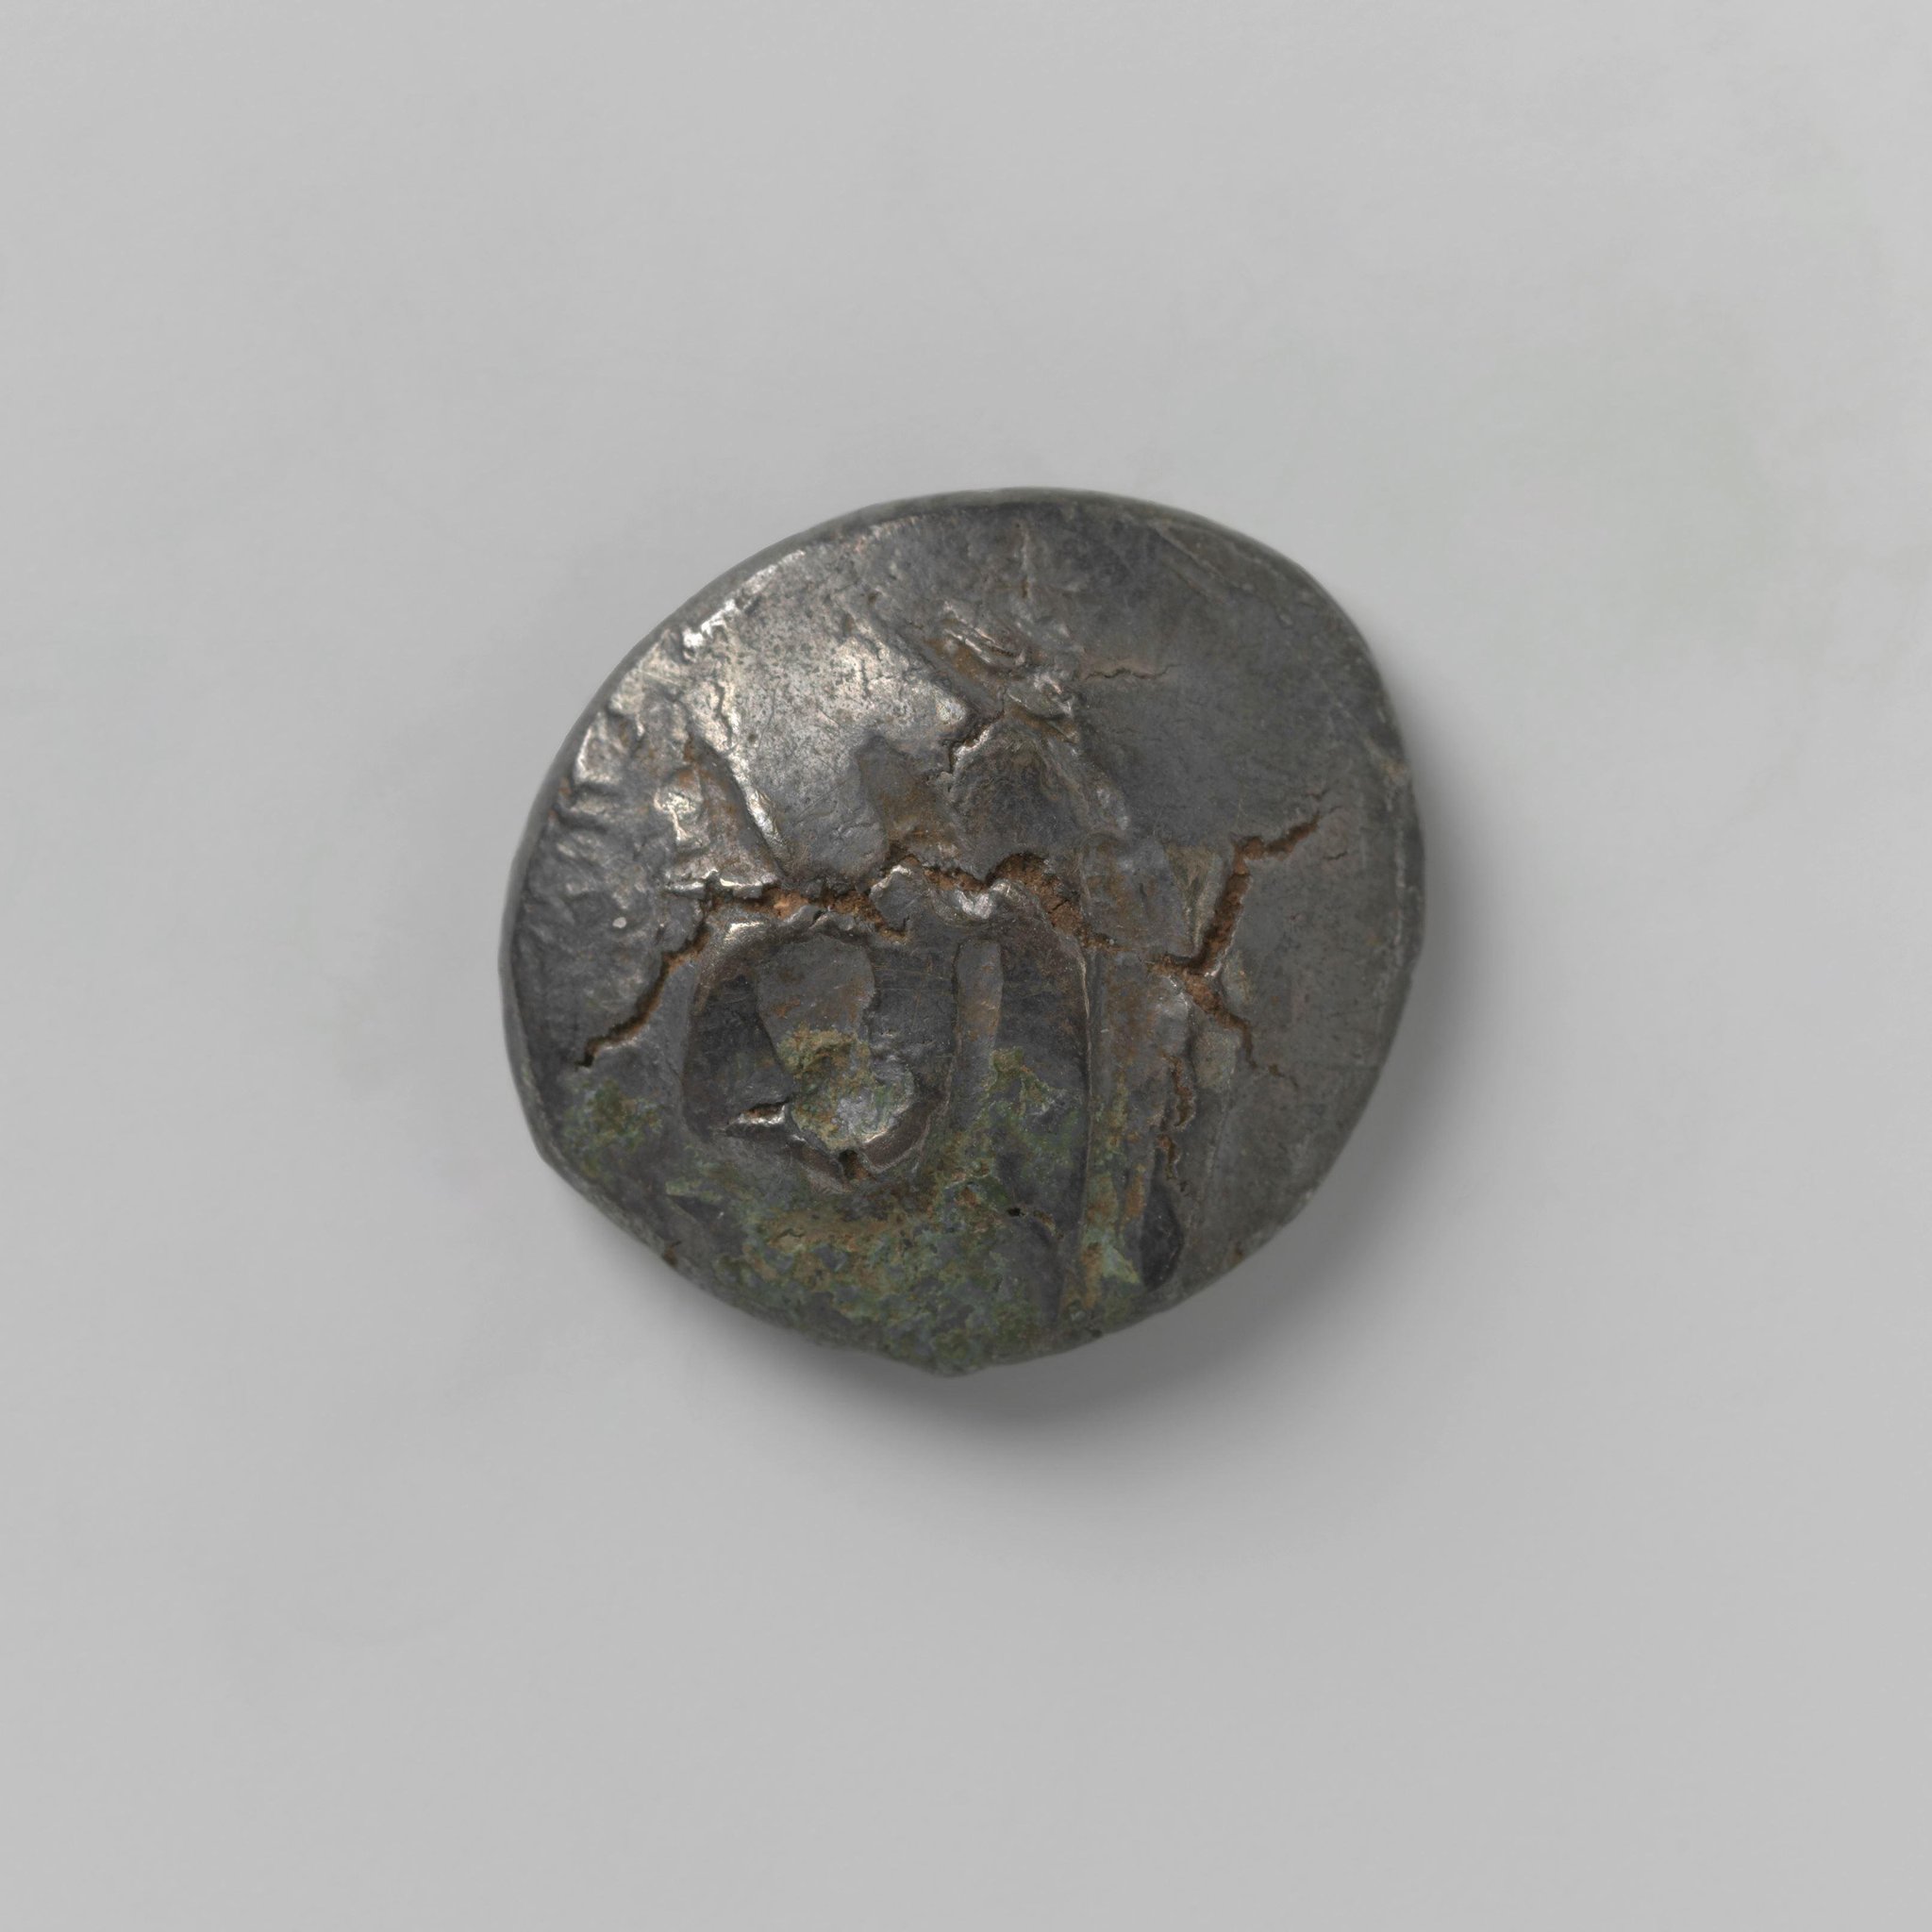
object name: coin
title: Djampel van koninkrijk Majopahit op Java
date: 1290-1520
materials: silver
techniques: striking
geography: java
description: Zilveren schotelvormige munt. Voorzijde: letterteken in devanagari-schrift [maa?]. Keerzijde, figuratie [bloem?].